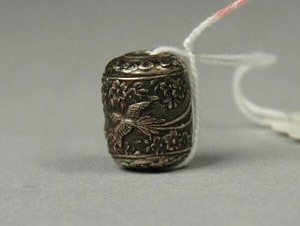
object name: ojime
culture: japanese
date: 1801-1900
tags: birds,flowers